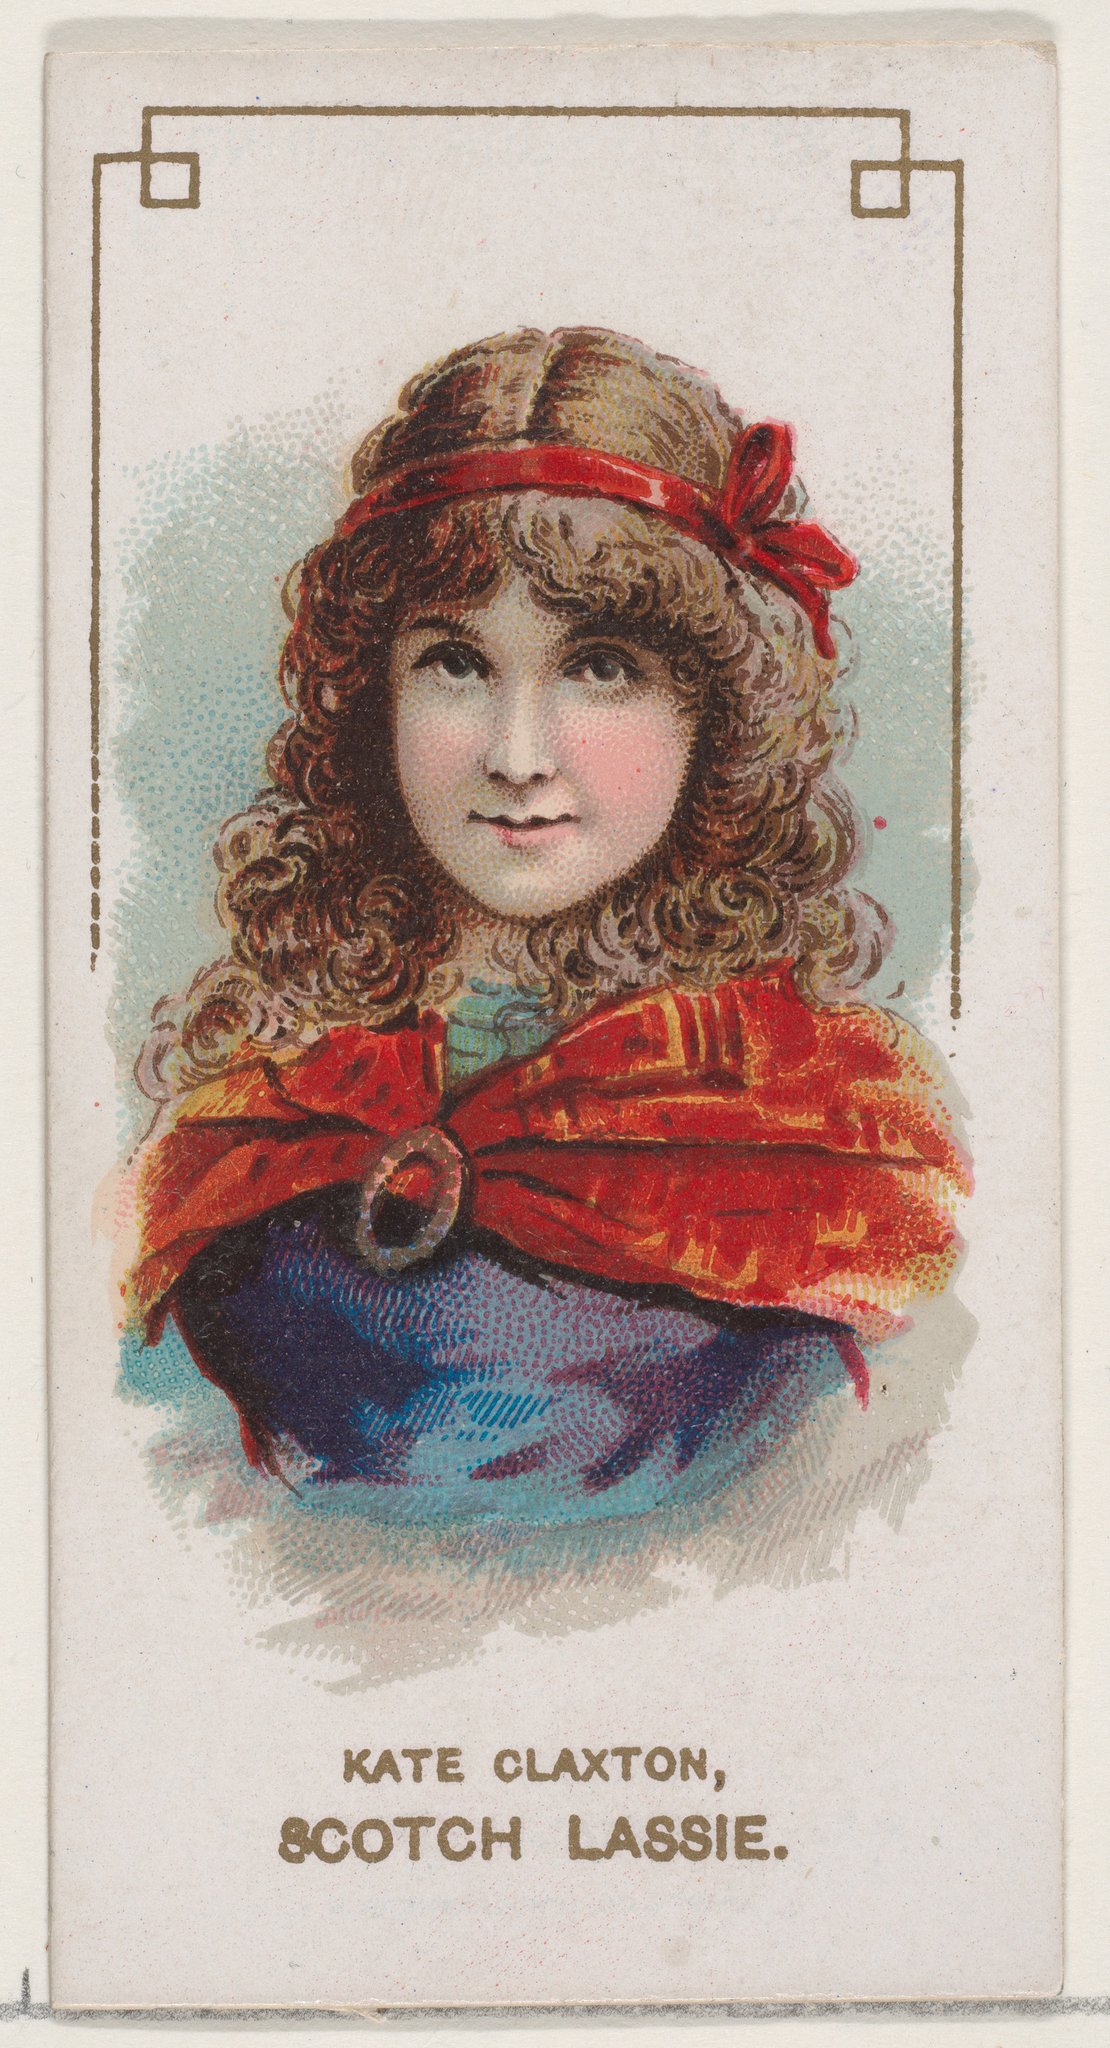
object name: print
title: Kate Claxton as Scotch Lassie, from the set Actors and Actresses, Second Series (N71) for Duke brand cigarettes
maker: w. duke, sons & co.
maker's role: publisher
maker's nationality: american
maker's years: 1870-1920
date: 1888-1890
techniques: color lithograph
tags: women,actresses